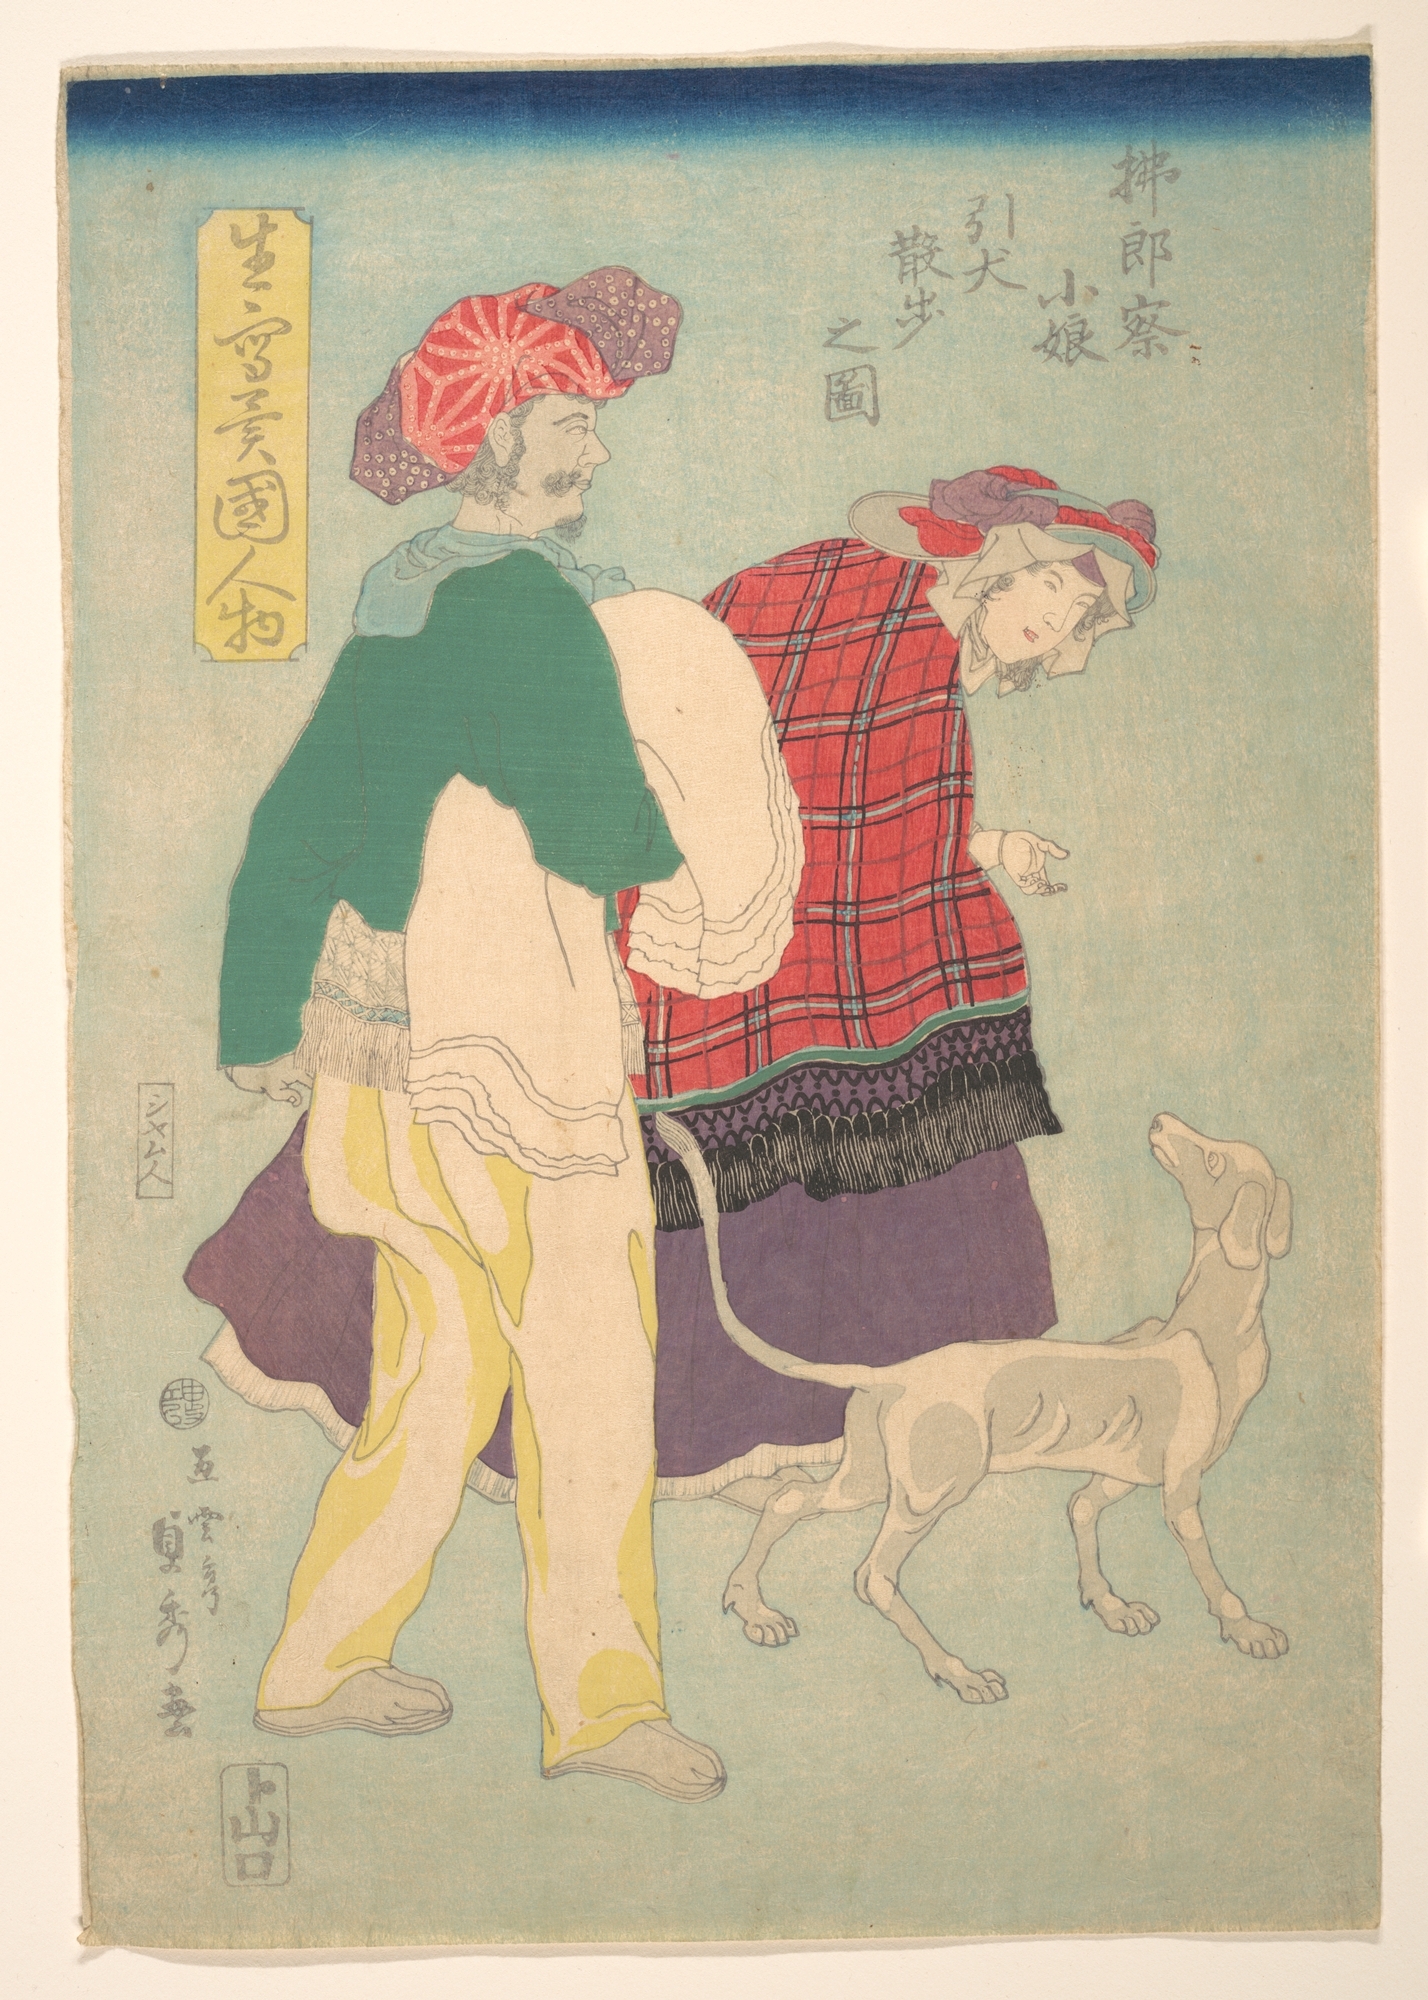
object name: print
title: French Girl Walking a Dog Accompanied by a Siamese Servant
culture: japanese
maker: utagawa (gountei) sadahide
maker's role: artist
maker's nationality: japanese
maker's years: 1807-1873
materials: ink, paper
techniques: woodblock print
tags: girls,men,dogs,servants